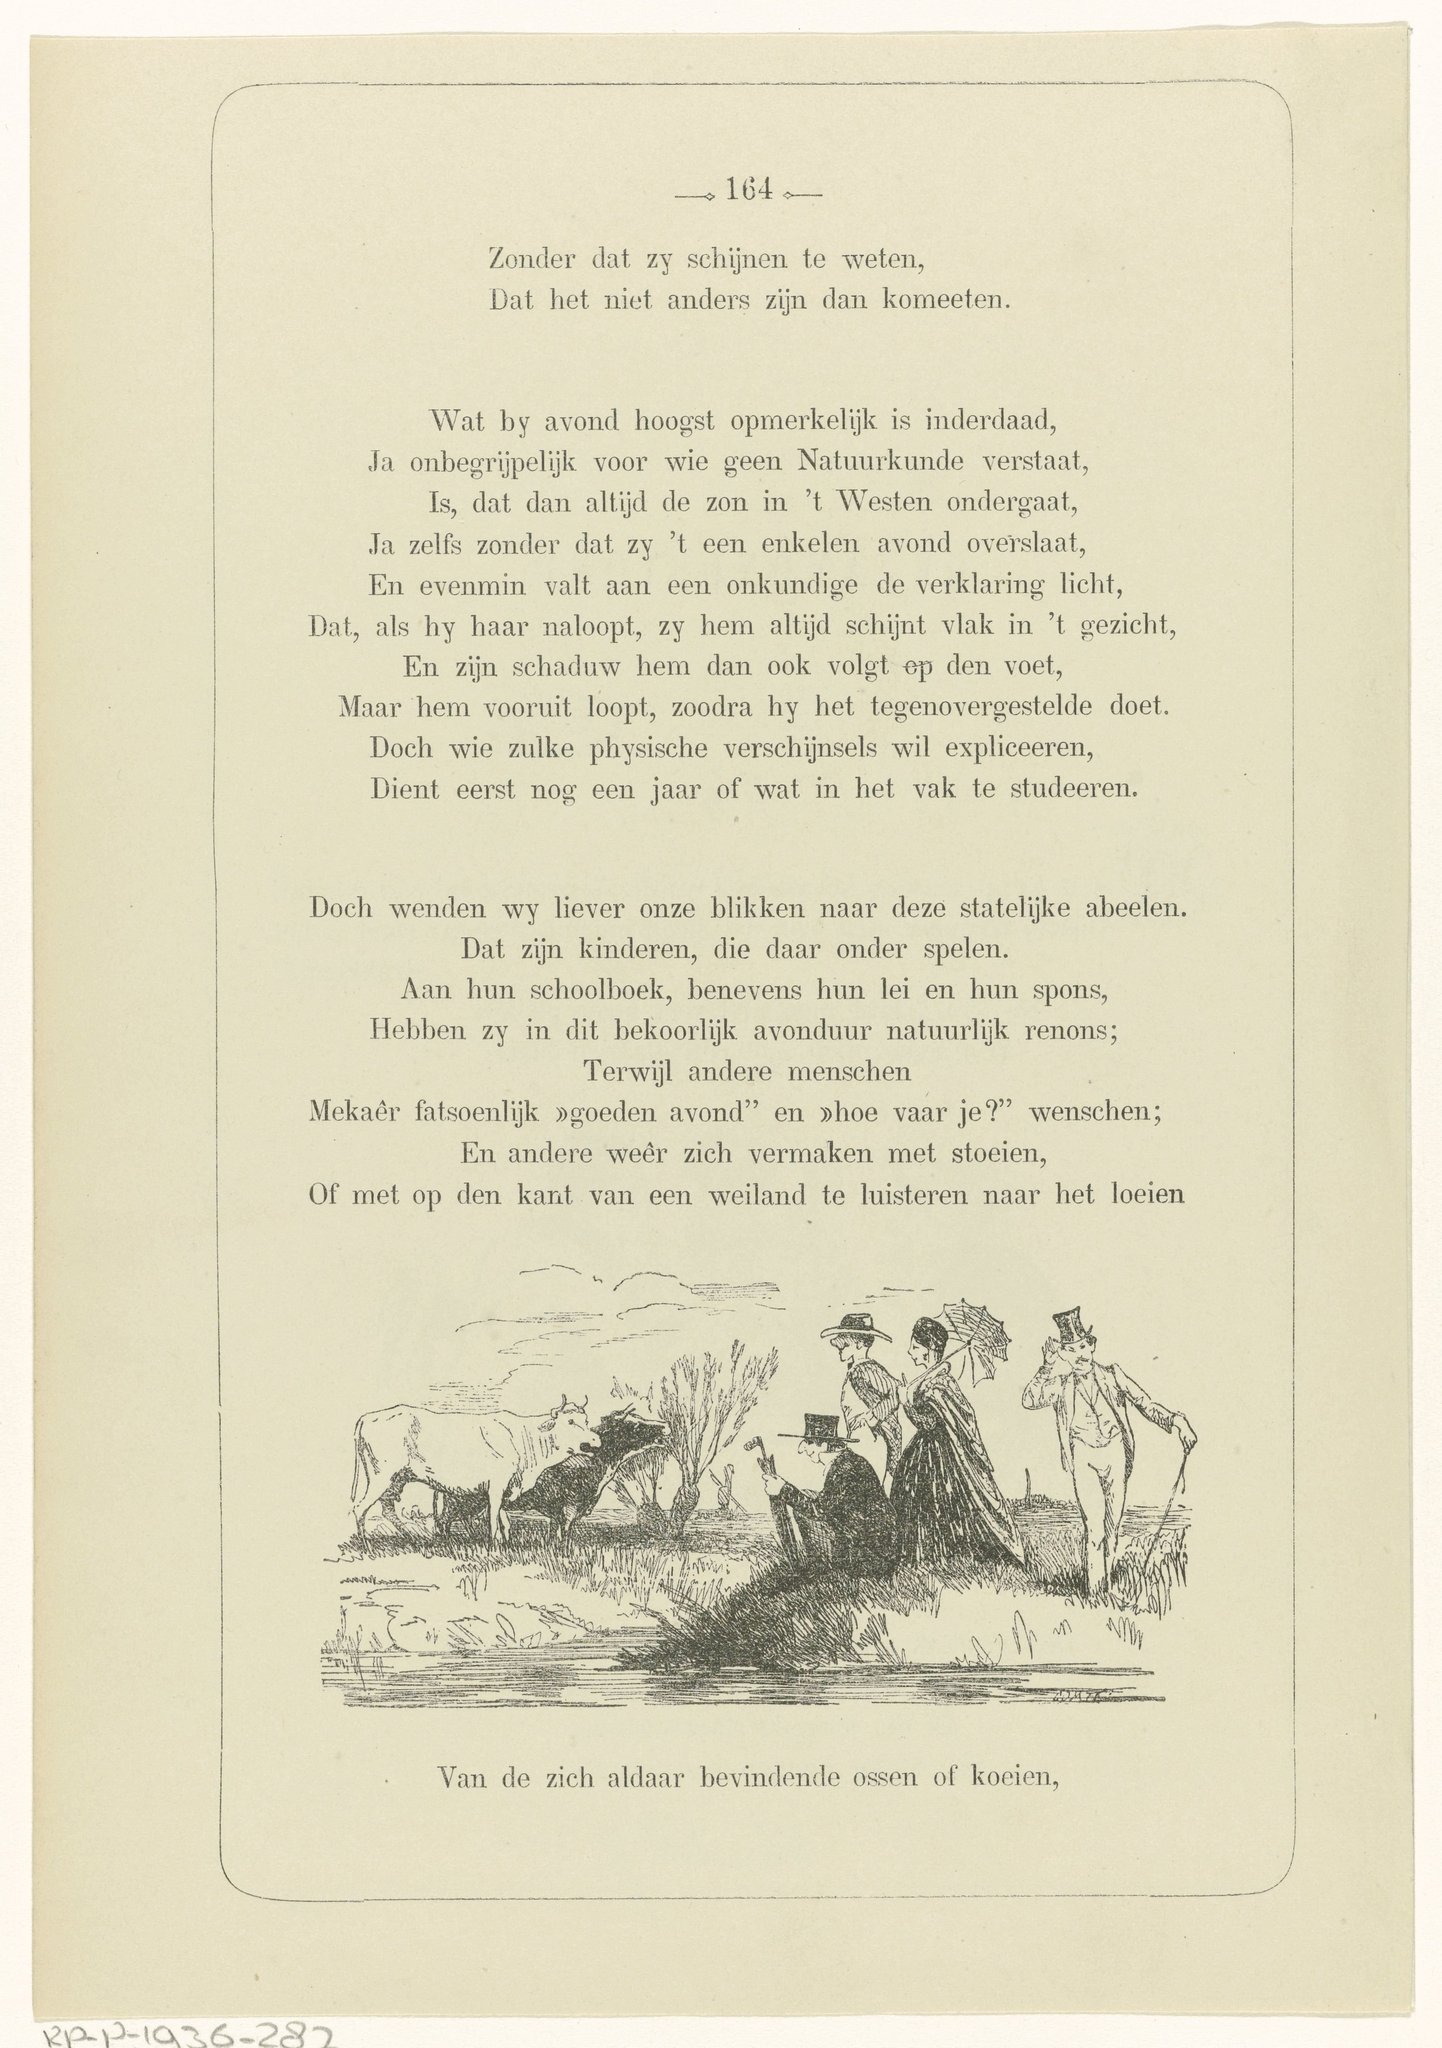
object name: print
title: De avondstond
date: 1872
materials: paper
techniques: letterpress printing, engraving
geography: amsterdam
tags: teacher and pupil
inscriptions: collector's mark: Lugt 2228, collector's mark: Lugt 2760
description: Prent uit: Schoolmeester, De. De gedichten van den Schoolmeester. Amsterdam: Jacob van Lennep, 1872.